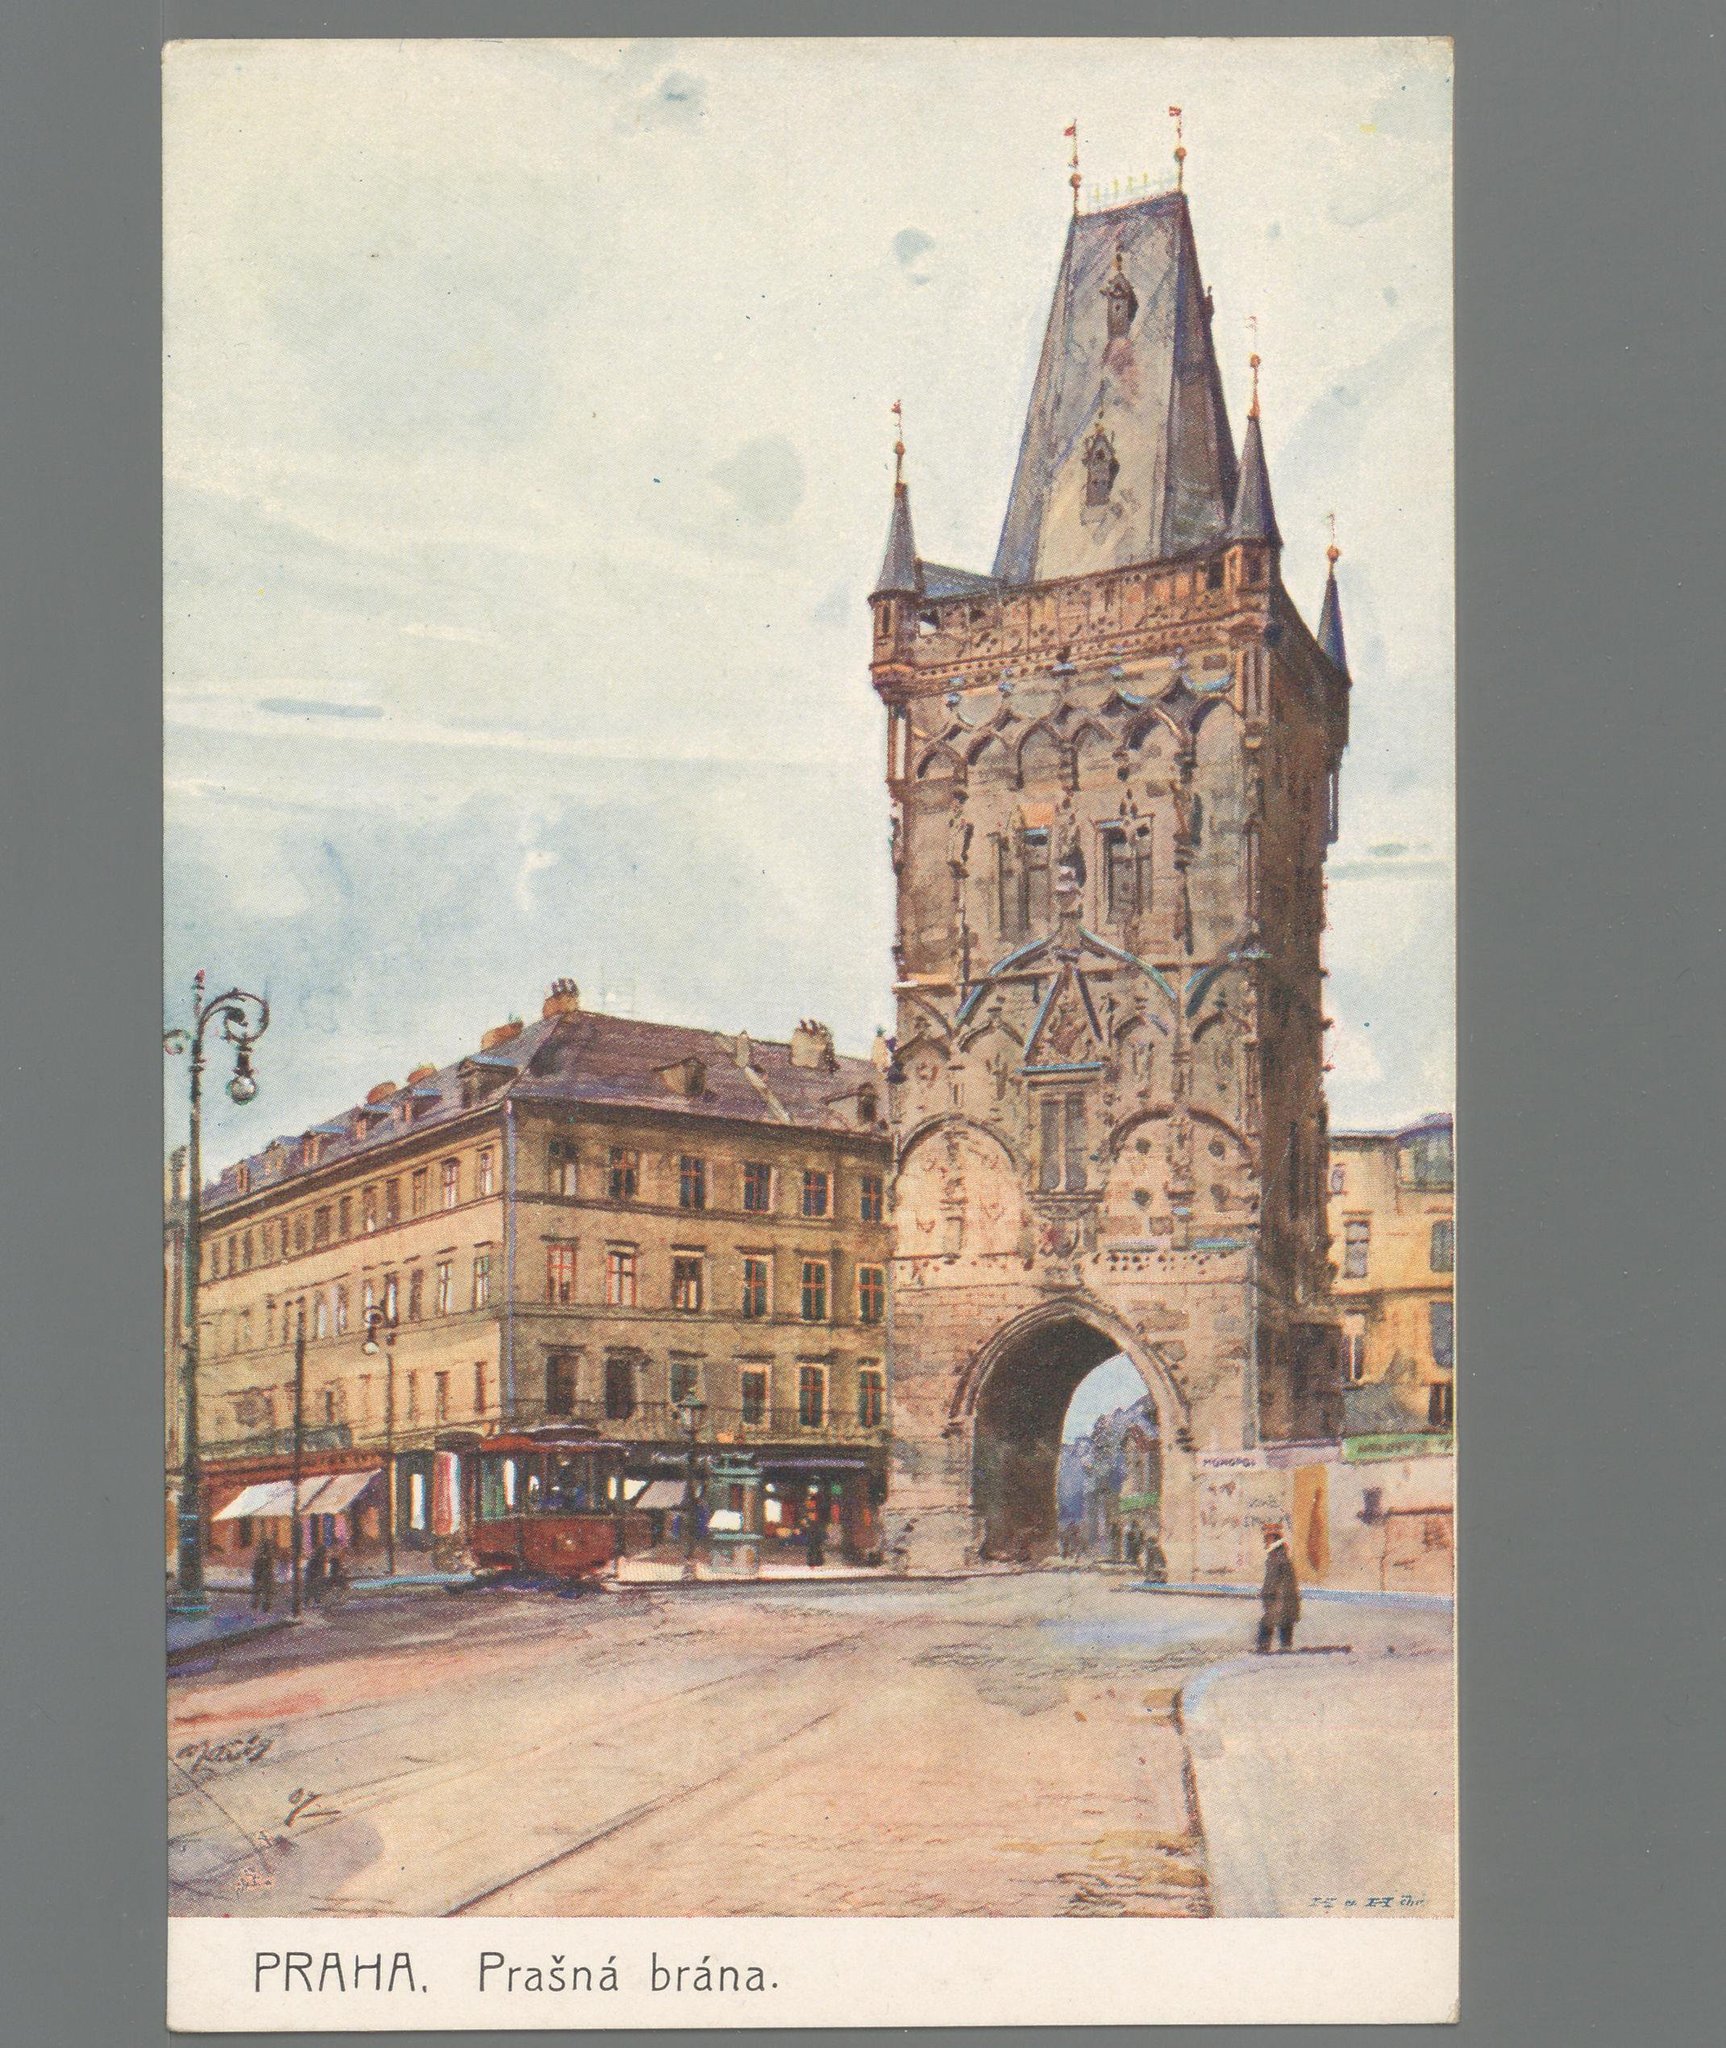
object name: photomechanical print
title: Praha. Prasná brána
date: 1906-1930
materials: cardboard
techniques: color autotype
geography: prague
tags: city-gate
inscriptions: inscription: ‘H&H’